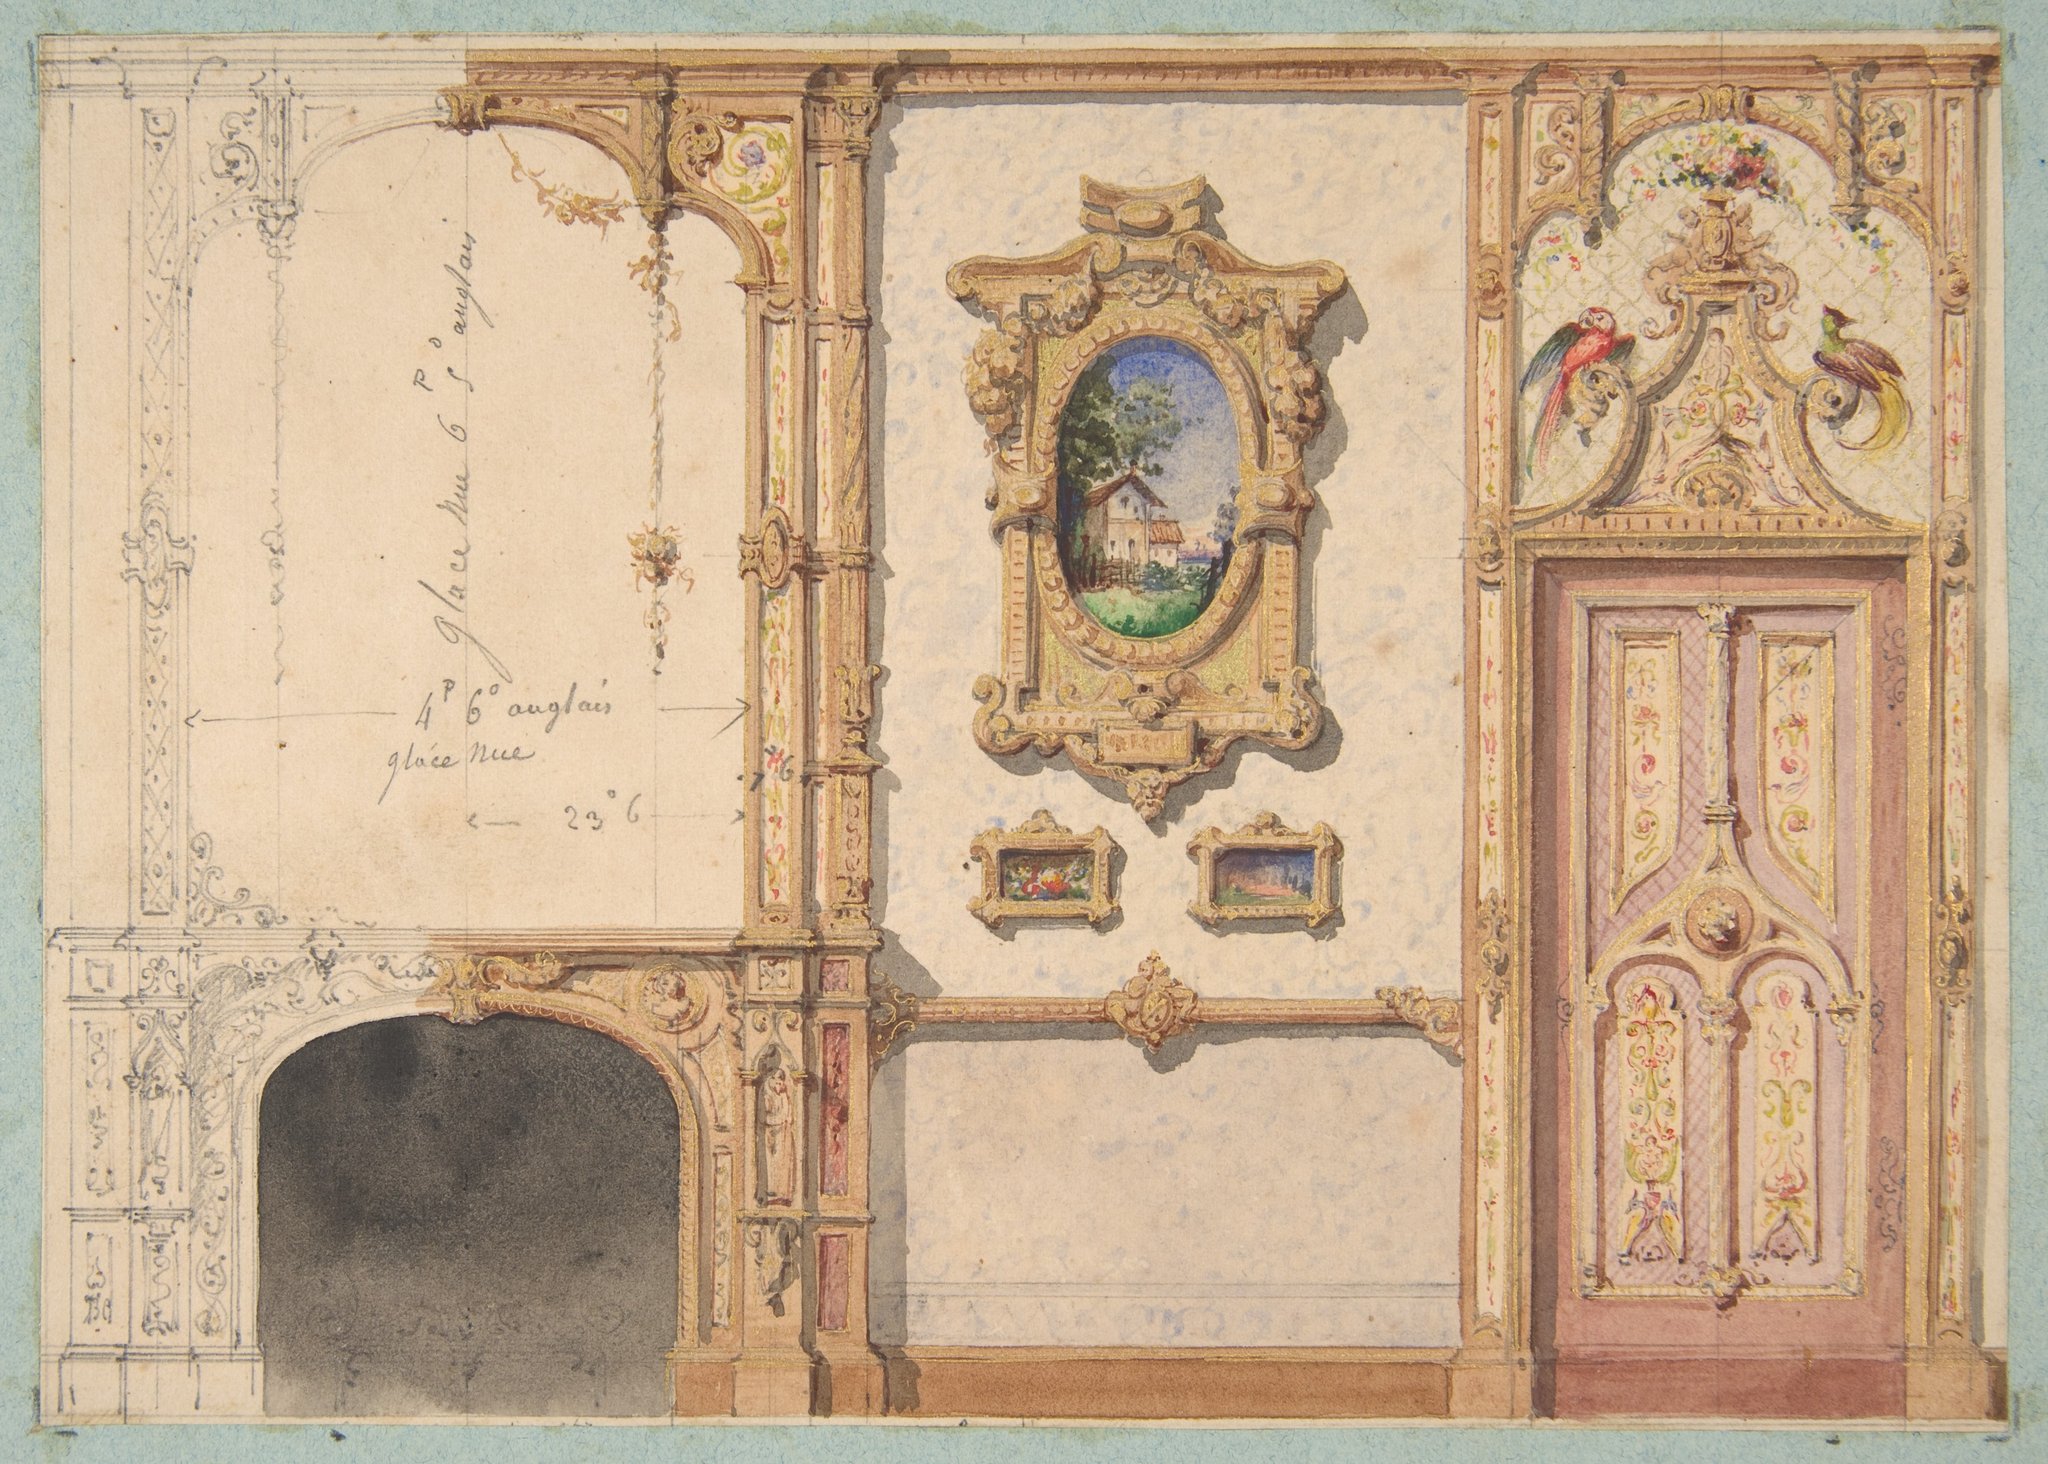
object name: drawing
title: Design for the decoration of a wall punctuated by a fireplace and a door and hung with gold-framed pictures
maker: jules-edmond-charles lachaise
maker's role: artist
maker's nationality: french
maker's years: 1897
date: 1830-1897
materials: gold paint, graphite, watercolor, paper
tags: birds,doors,fireplaces